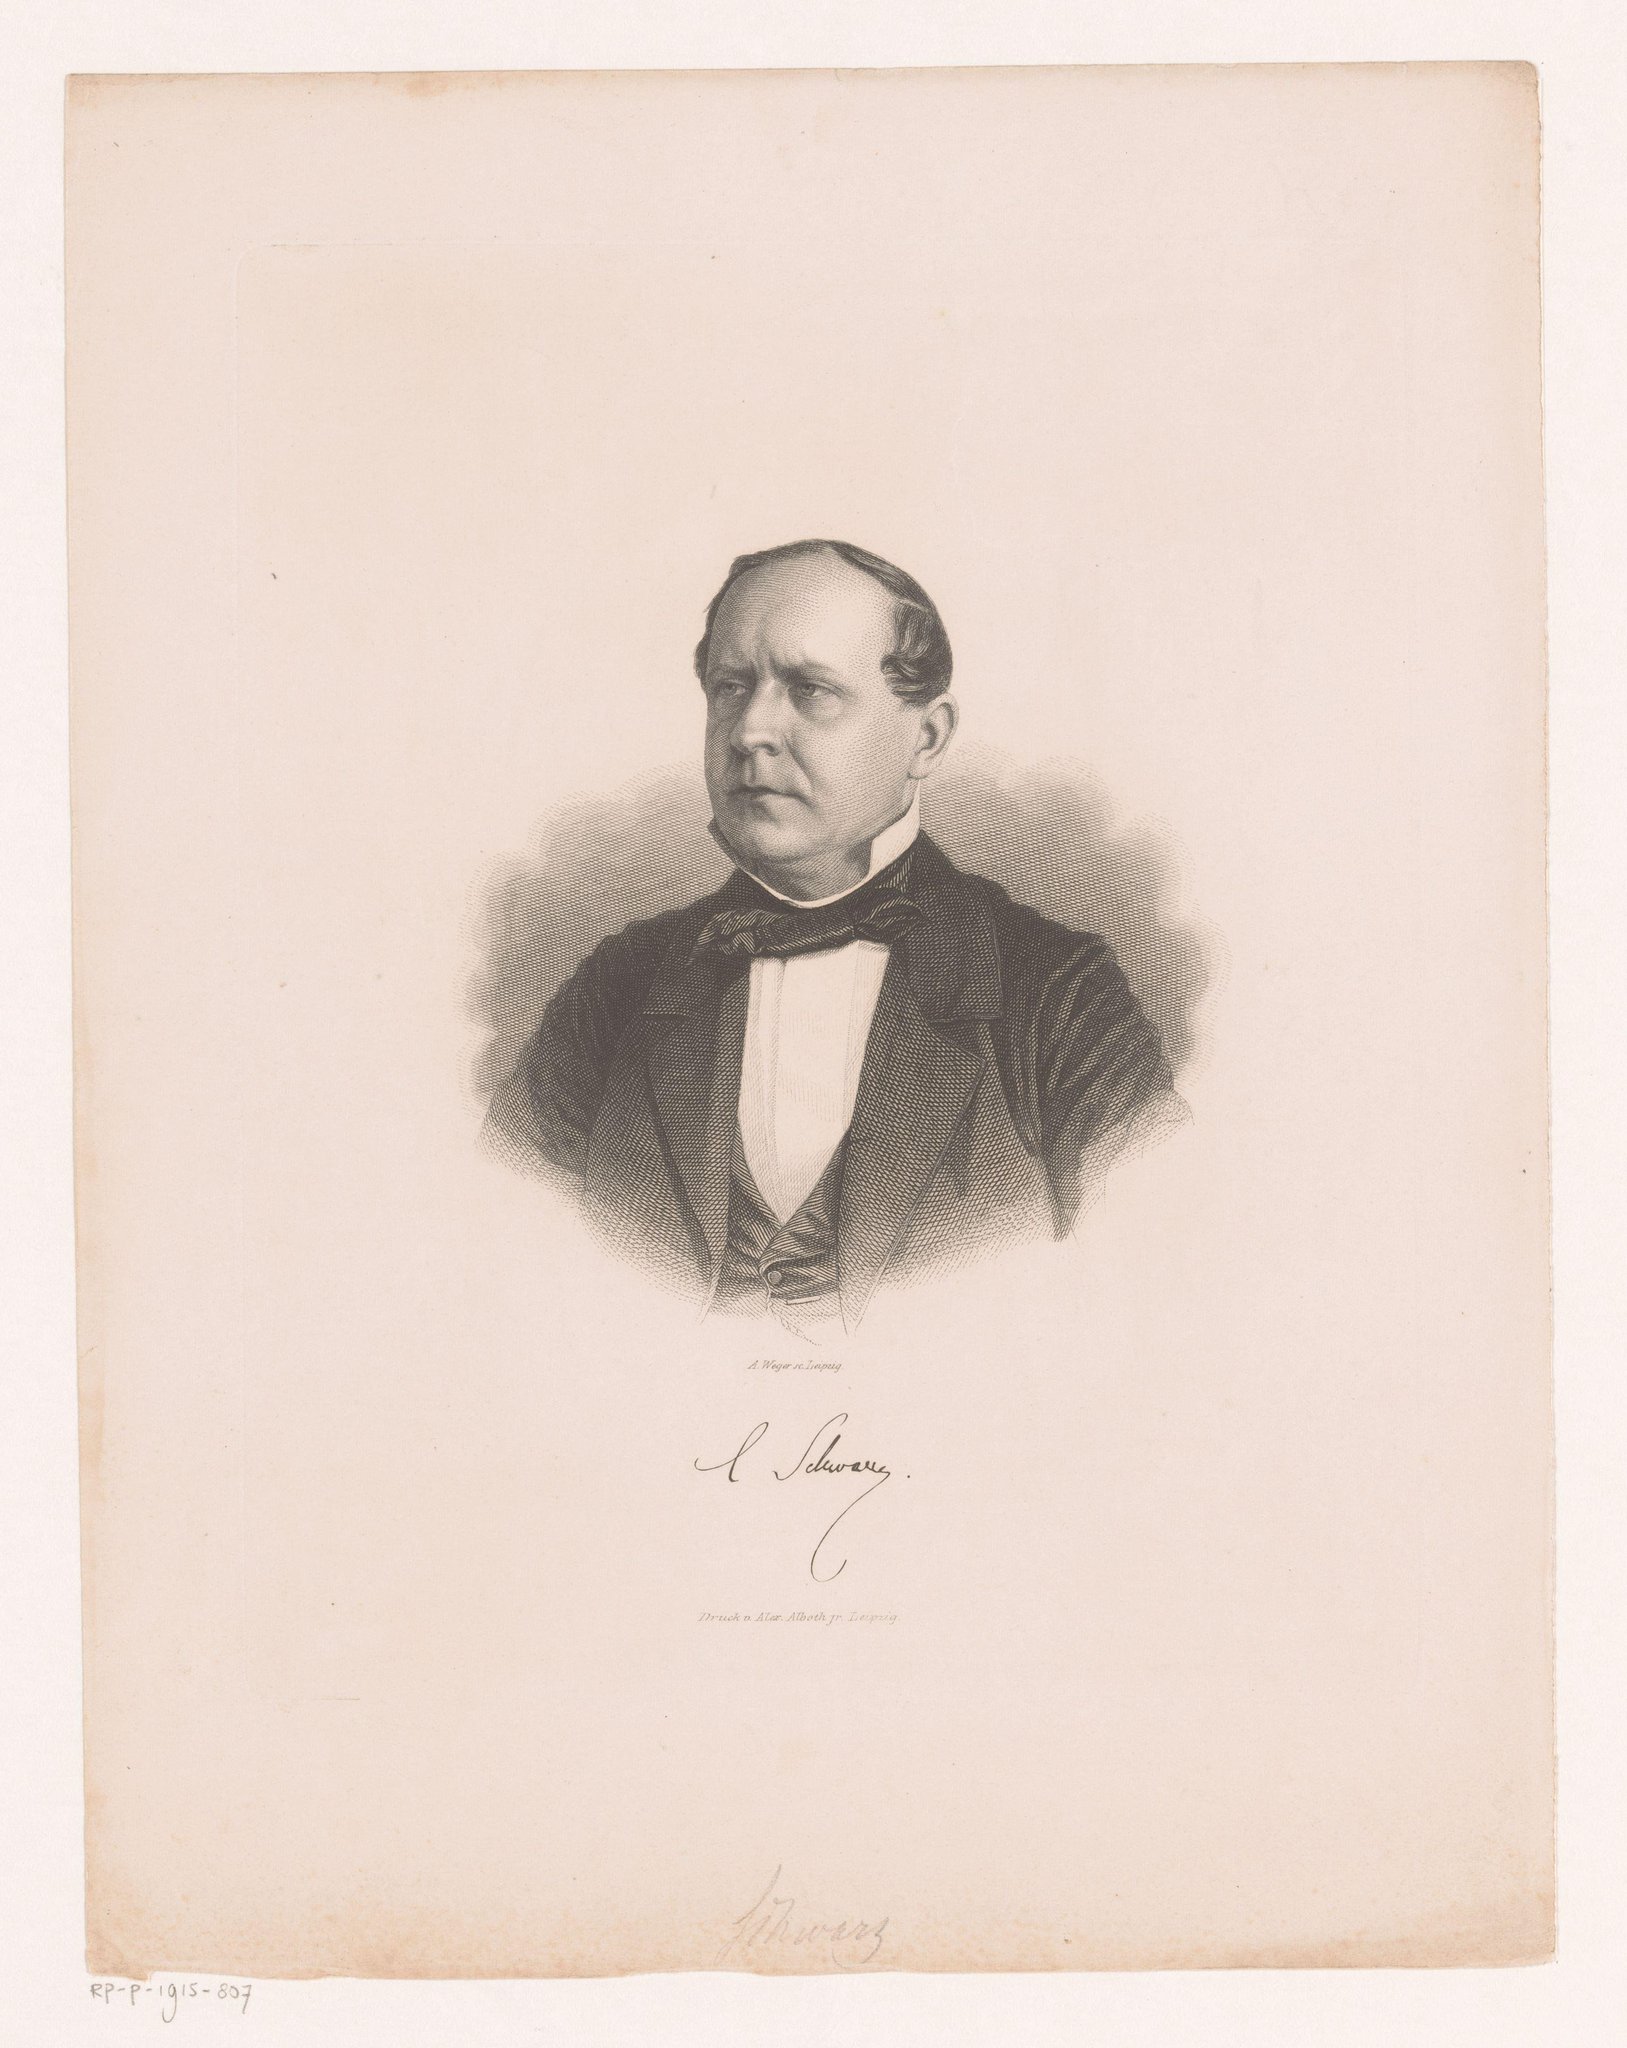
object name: print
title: Portret van Karl Schwarz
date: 1855-1892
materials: paper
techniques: engraving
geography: leipzig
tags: historical persons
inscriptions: collector's mark: Lugt 2228